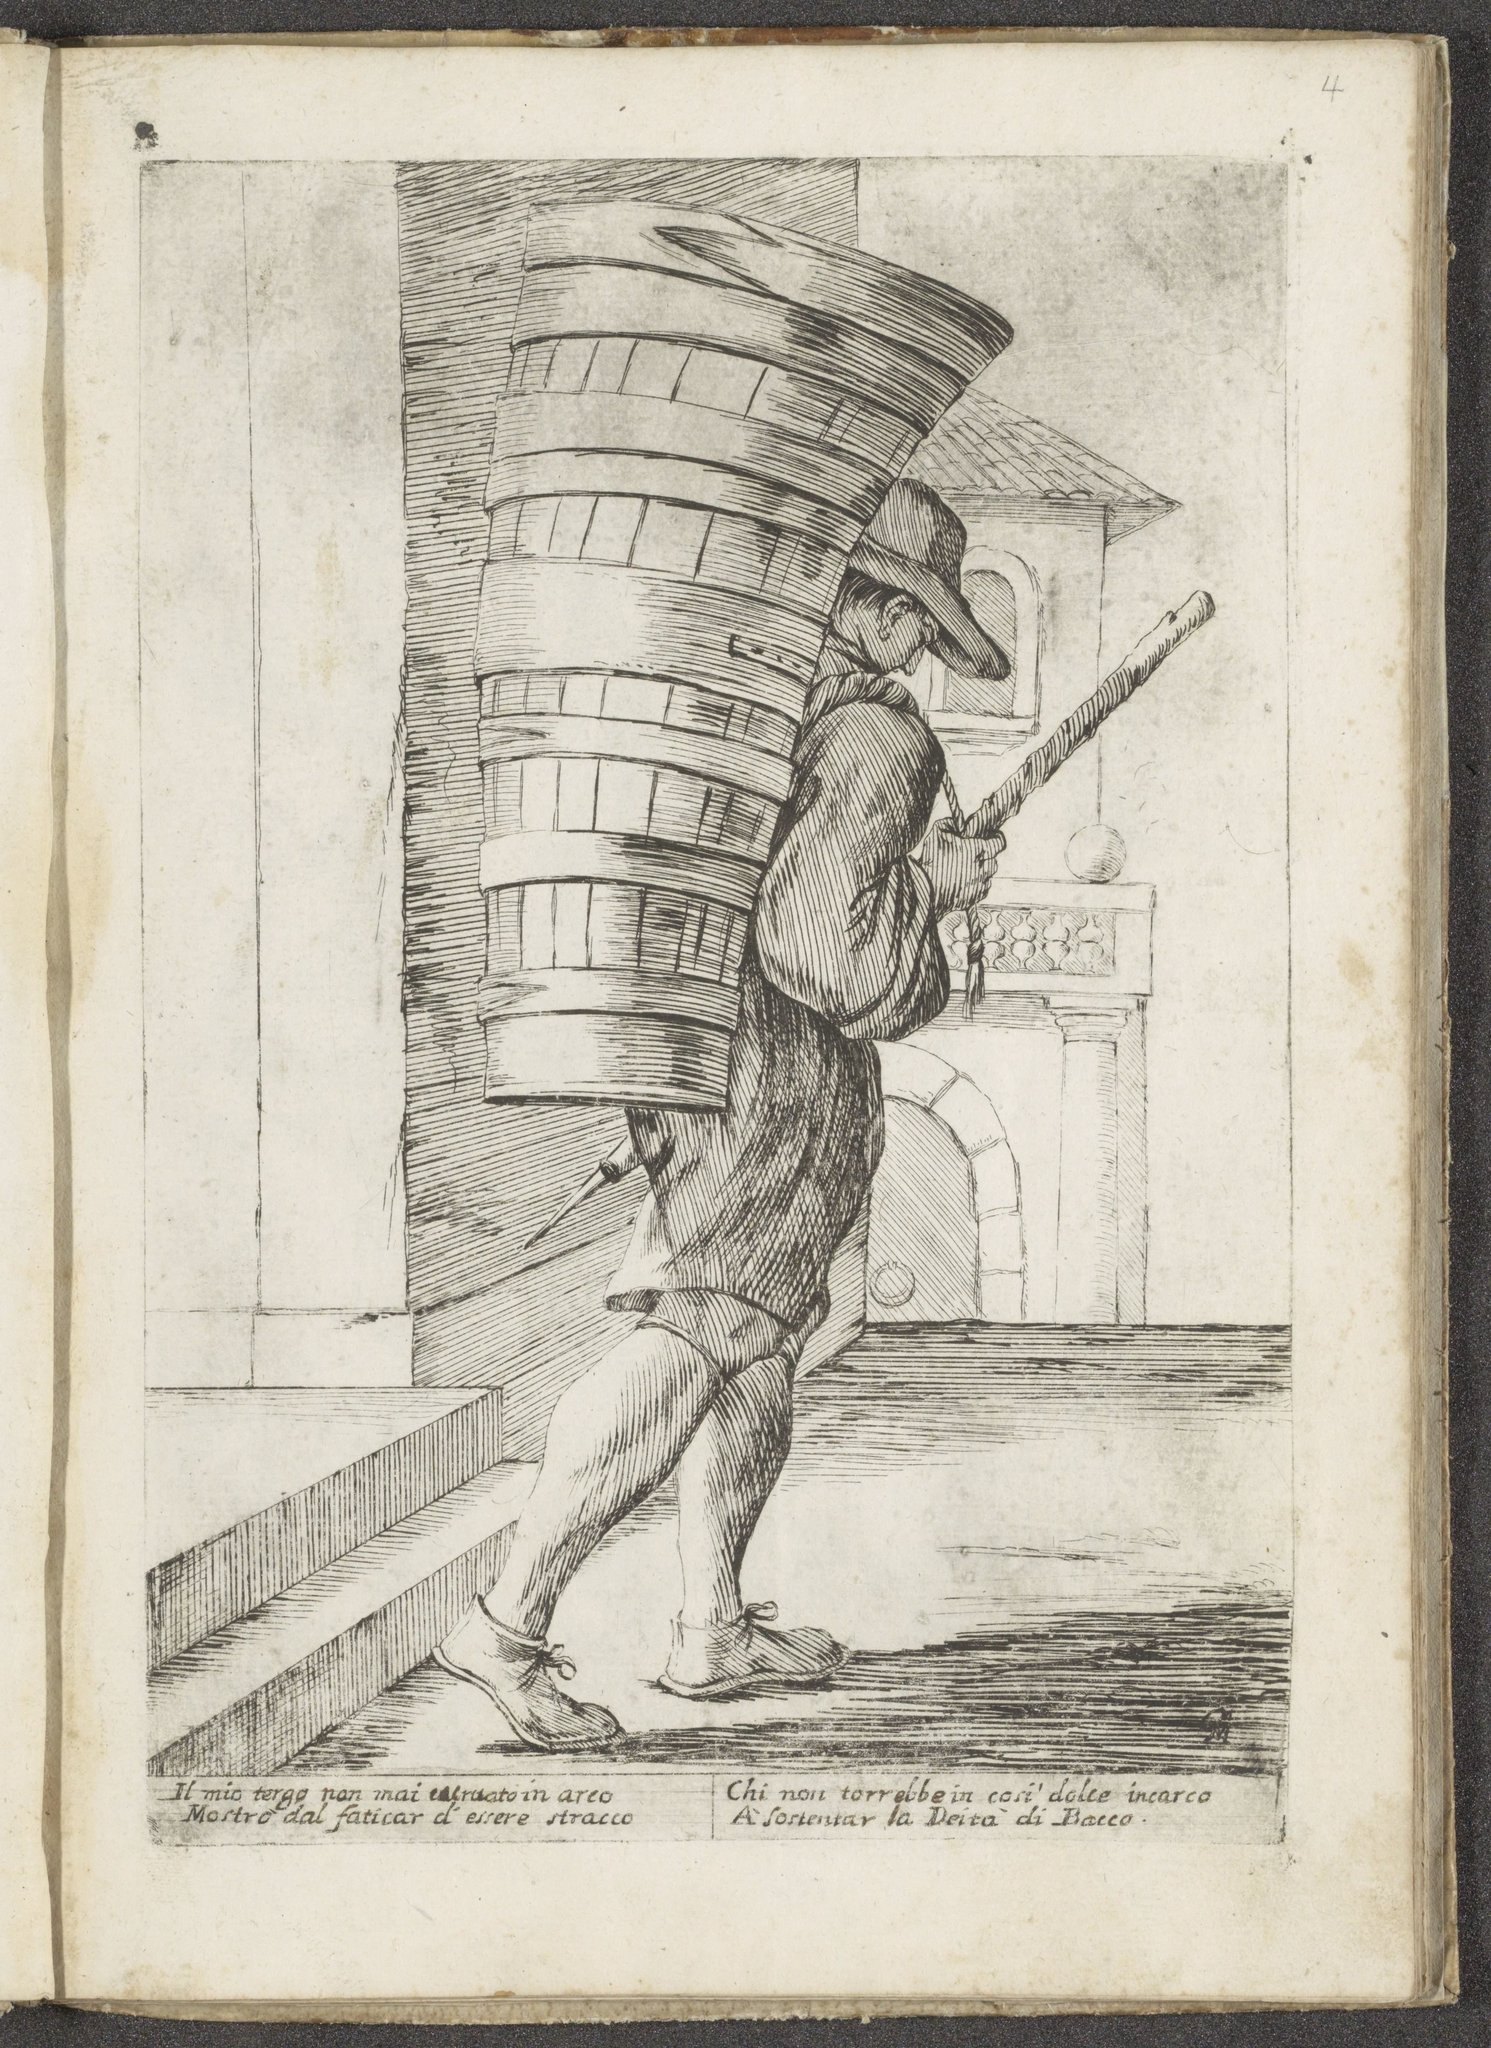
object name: album leaf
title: Verkoper van wijn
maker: giuseppe maria mitelli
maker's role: draughtsman, painter, print maker, publisher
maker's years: 1634-1718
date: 1660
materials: paper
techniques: etching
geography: bologna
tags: wooden container: barrel, cask, bucket, carrying something in basket, bag, rucksack, etc., wine ~ alcoholic drinks, street-trader, 'cris de paris', cries of london, etc.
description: Een man loopt door een straat met een groot houten wijnvat op zijn rug. Italiaans vers in ondermarge. De prent maakt deel uit van een album.